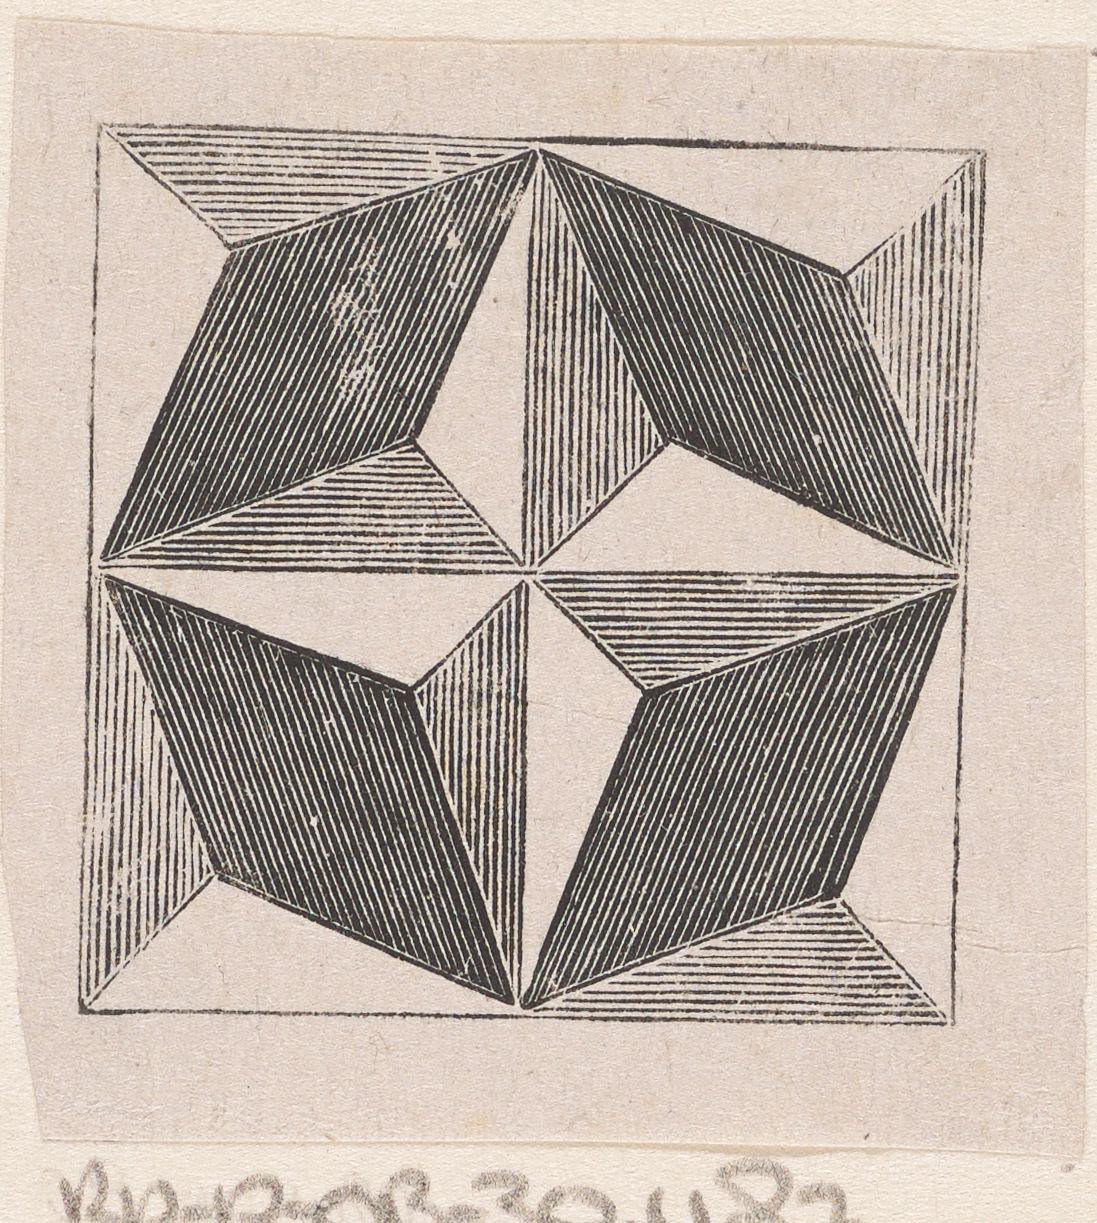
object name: print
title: Vignet met geometrische vormen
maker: isaac weissenbruch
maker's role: print maker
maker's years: 1826-1912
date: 1836-1912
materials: paper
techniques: engraving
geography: netherlands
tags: vignette, planimetry, geometry